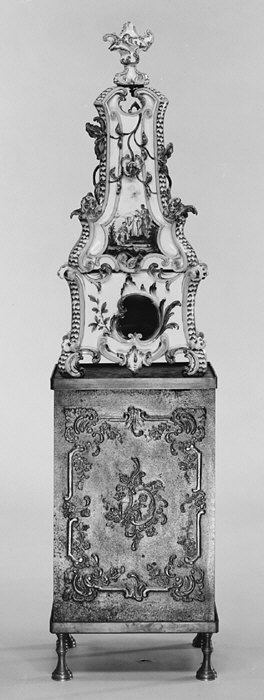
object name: stove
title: Ceramic stove on cast-iron firebox (one of a pair)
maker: abraham leihamer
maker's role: artist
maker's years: 1745-1774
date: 1773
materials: earthenware, gilt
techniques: glazing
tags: flowers,landscapes,trees,boats